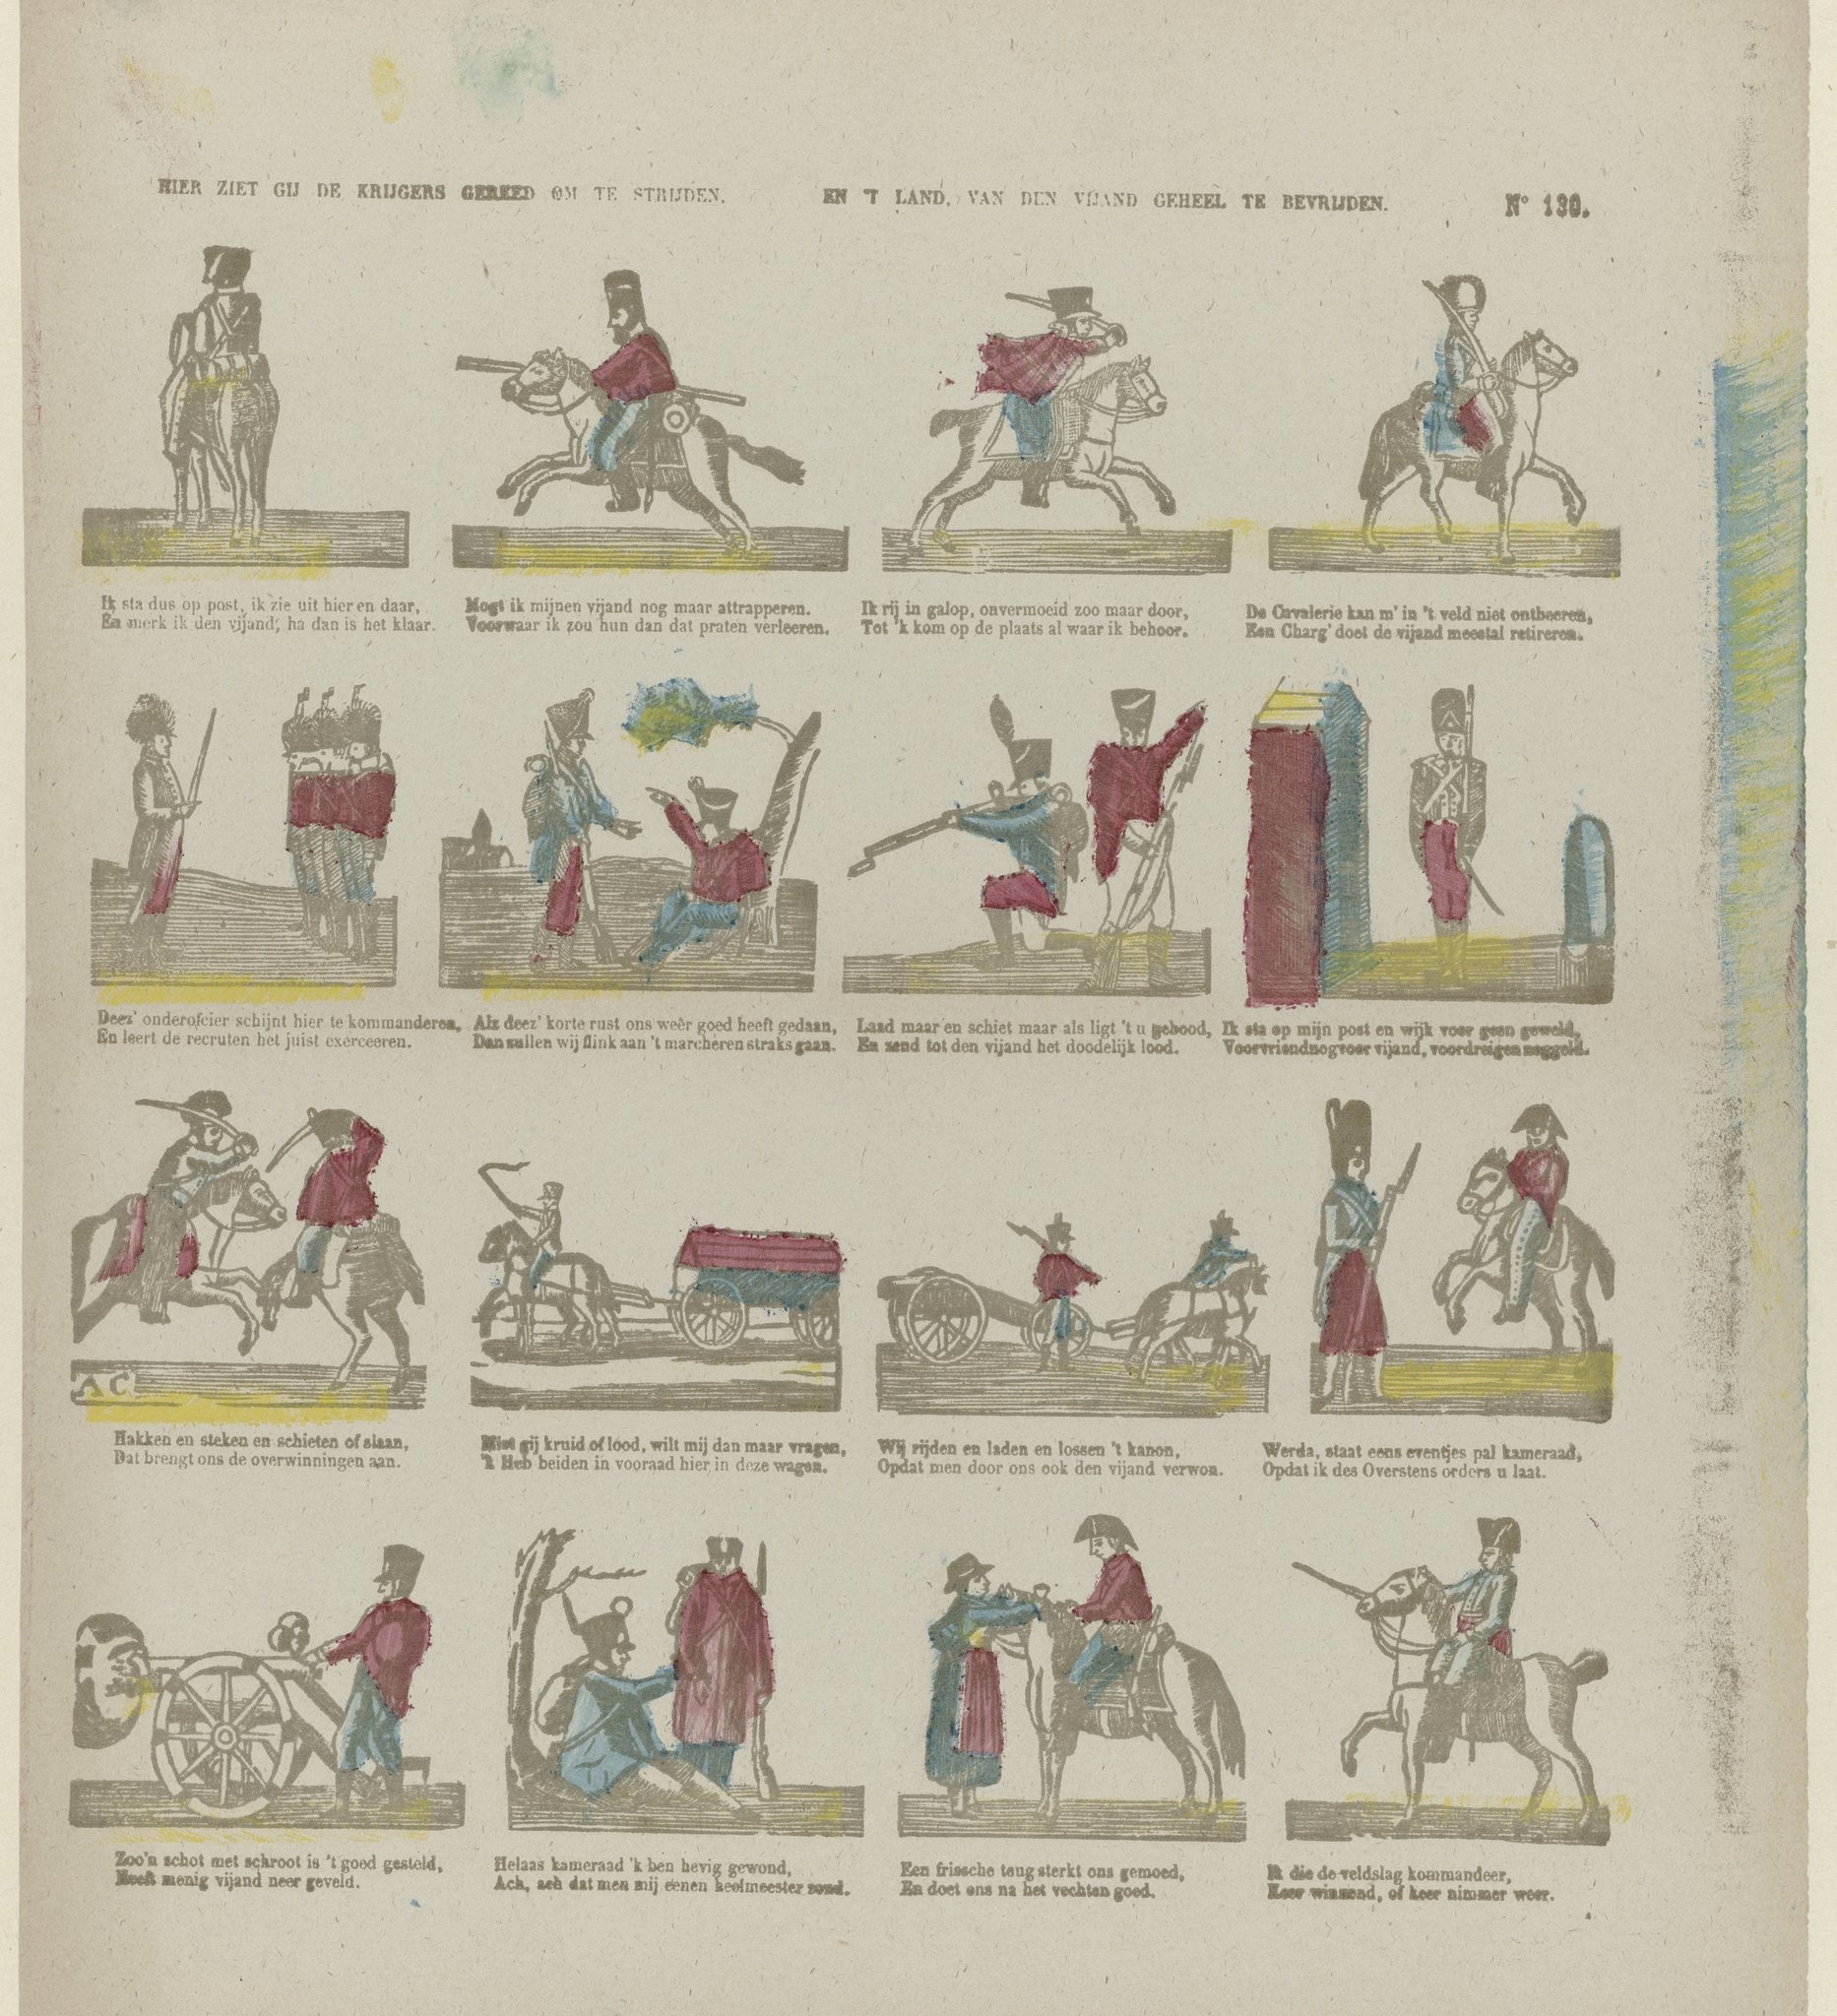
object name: print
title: Hier ziet gij de krijgers gereed om te strijden, / En 't land, van den vijand geheel te bevrijden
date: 1827-1894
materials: paper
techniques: printing, colour, letterpress printing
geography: netherlands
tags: artillery range, firing range, shooting range ~ military training, warfare; military affairs (+ cavalry, horsemen), the soldier; the soldier's life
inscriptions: collector's mark: Lugt 2760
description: Blad met 16 voorstellingen van militairen. Onder elke afbeelding een tweeregelig vers. Genummerd rechtsboven: No 130.